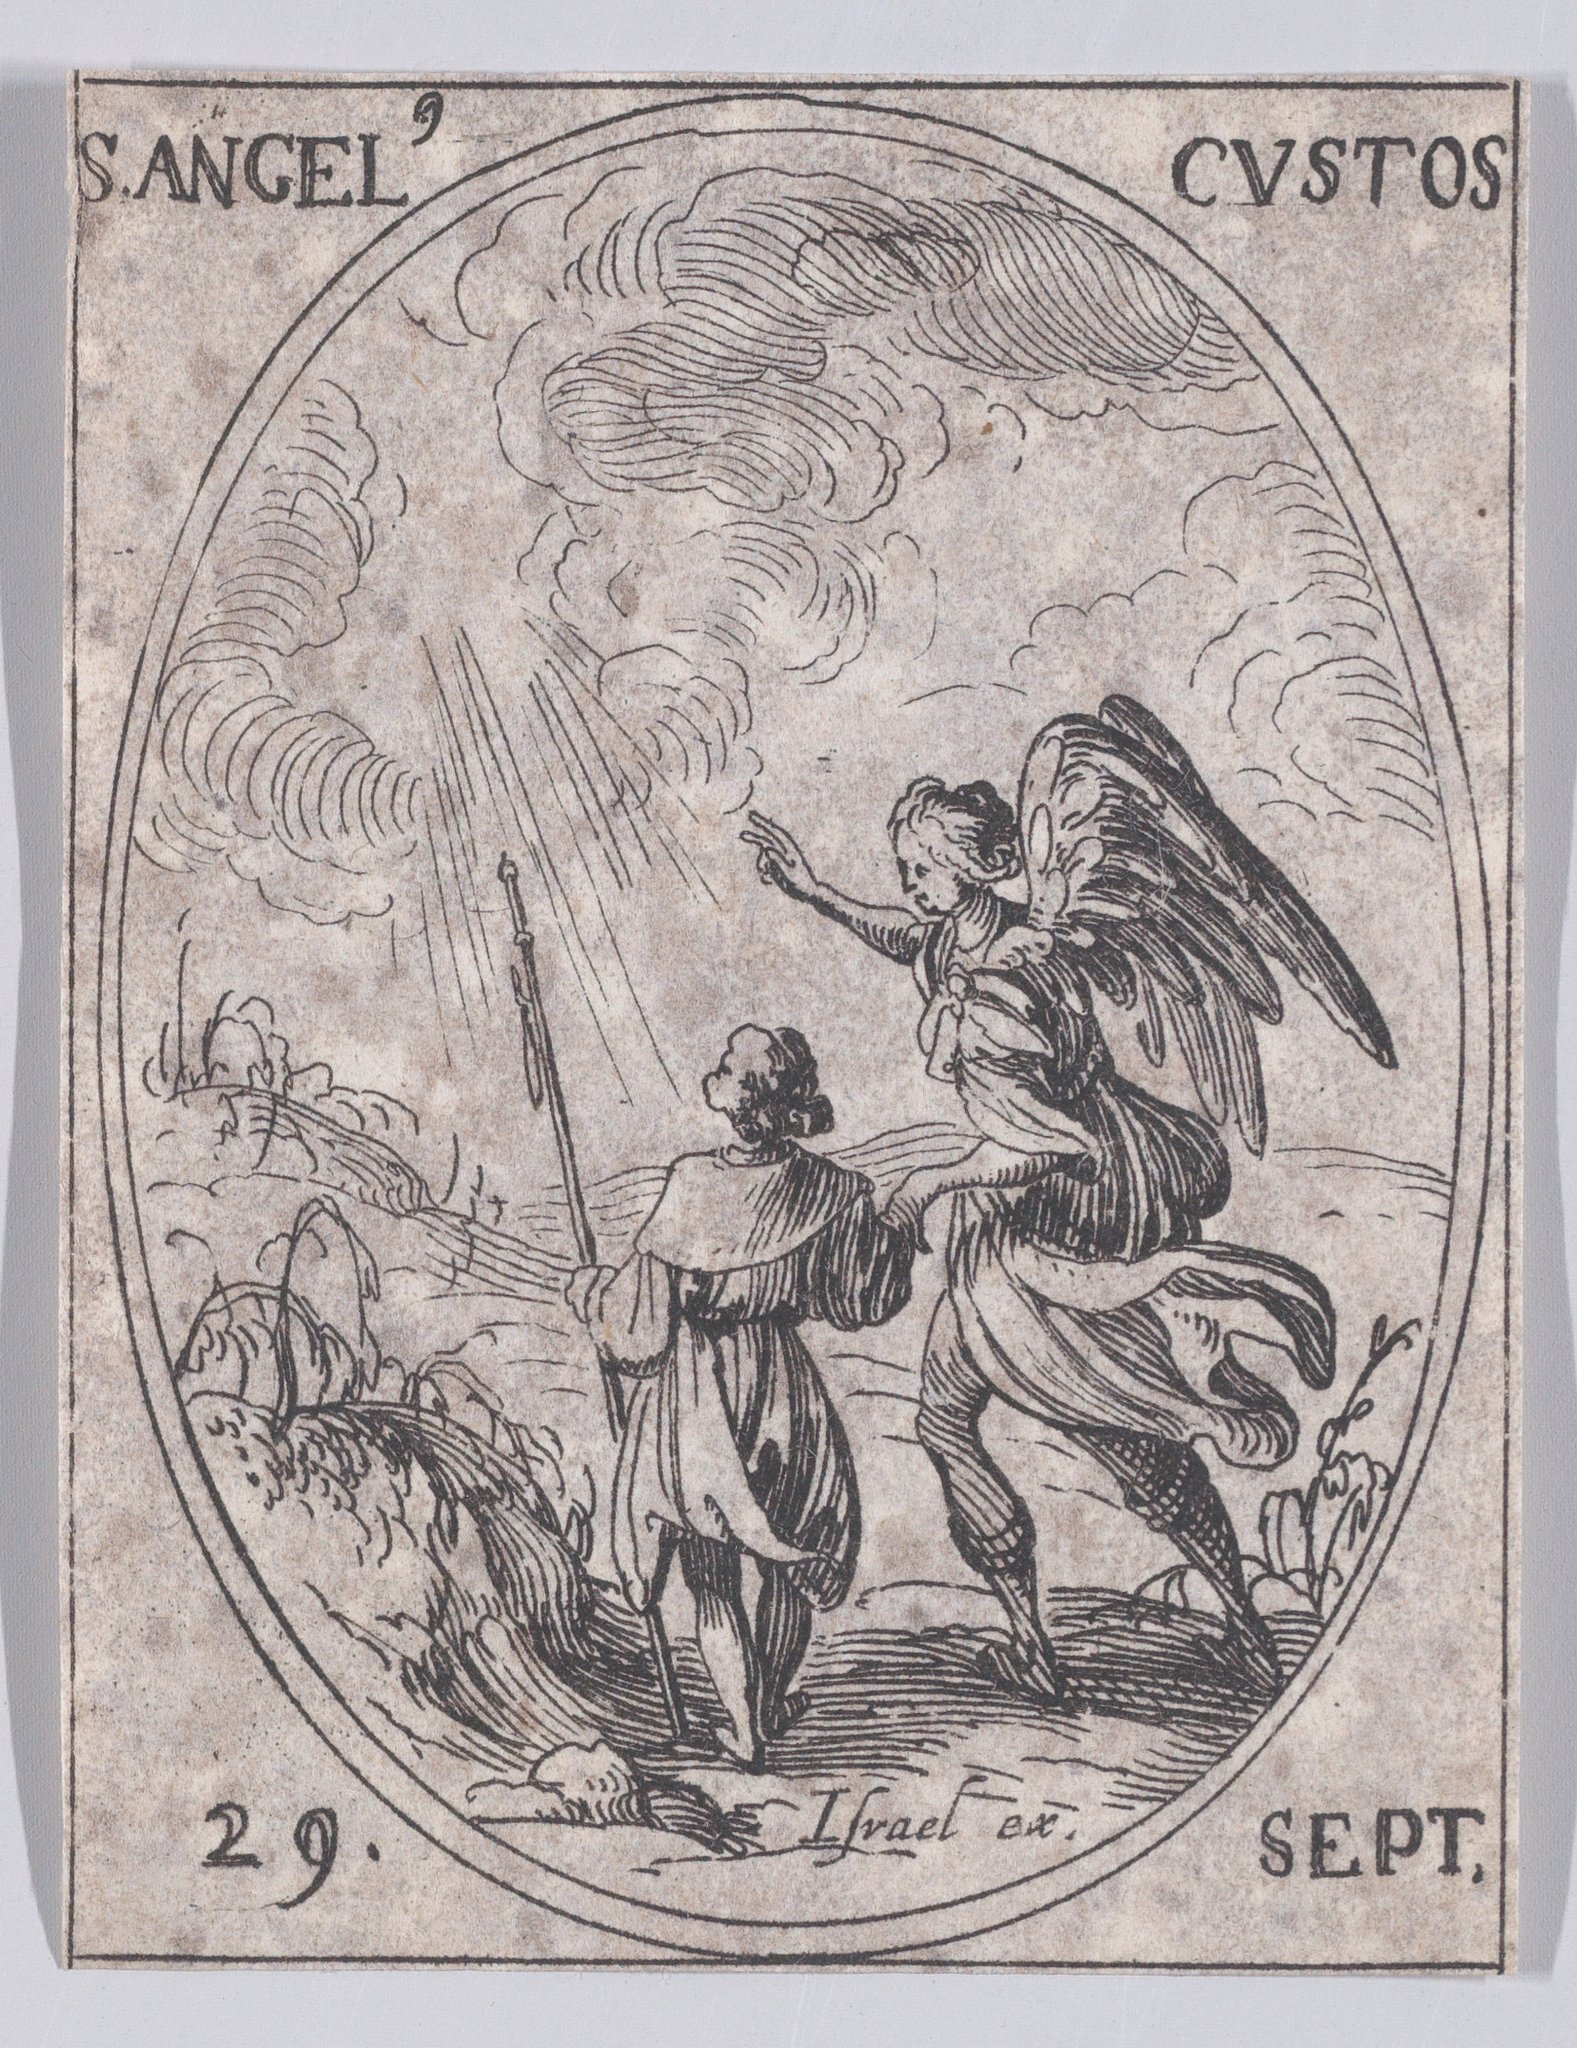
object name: print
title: Le Saint Ange Gardien (The Guardian Angel), September 29th, from "Les Images De Tous Les Saincts et Saintes de L'Année" (Images of All of the Saints and Religious Events of the Year)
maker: jacques callot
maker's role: artist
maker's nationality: french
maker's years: 1592-1635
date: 1636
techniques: etching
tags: angels